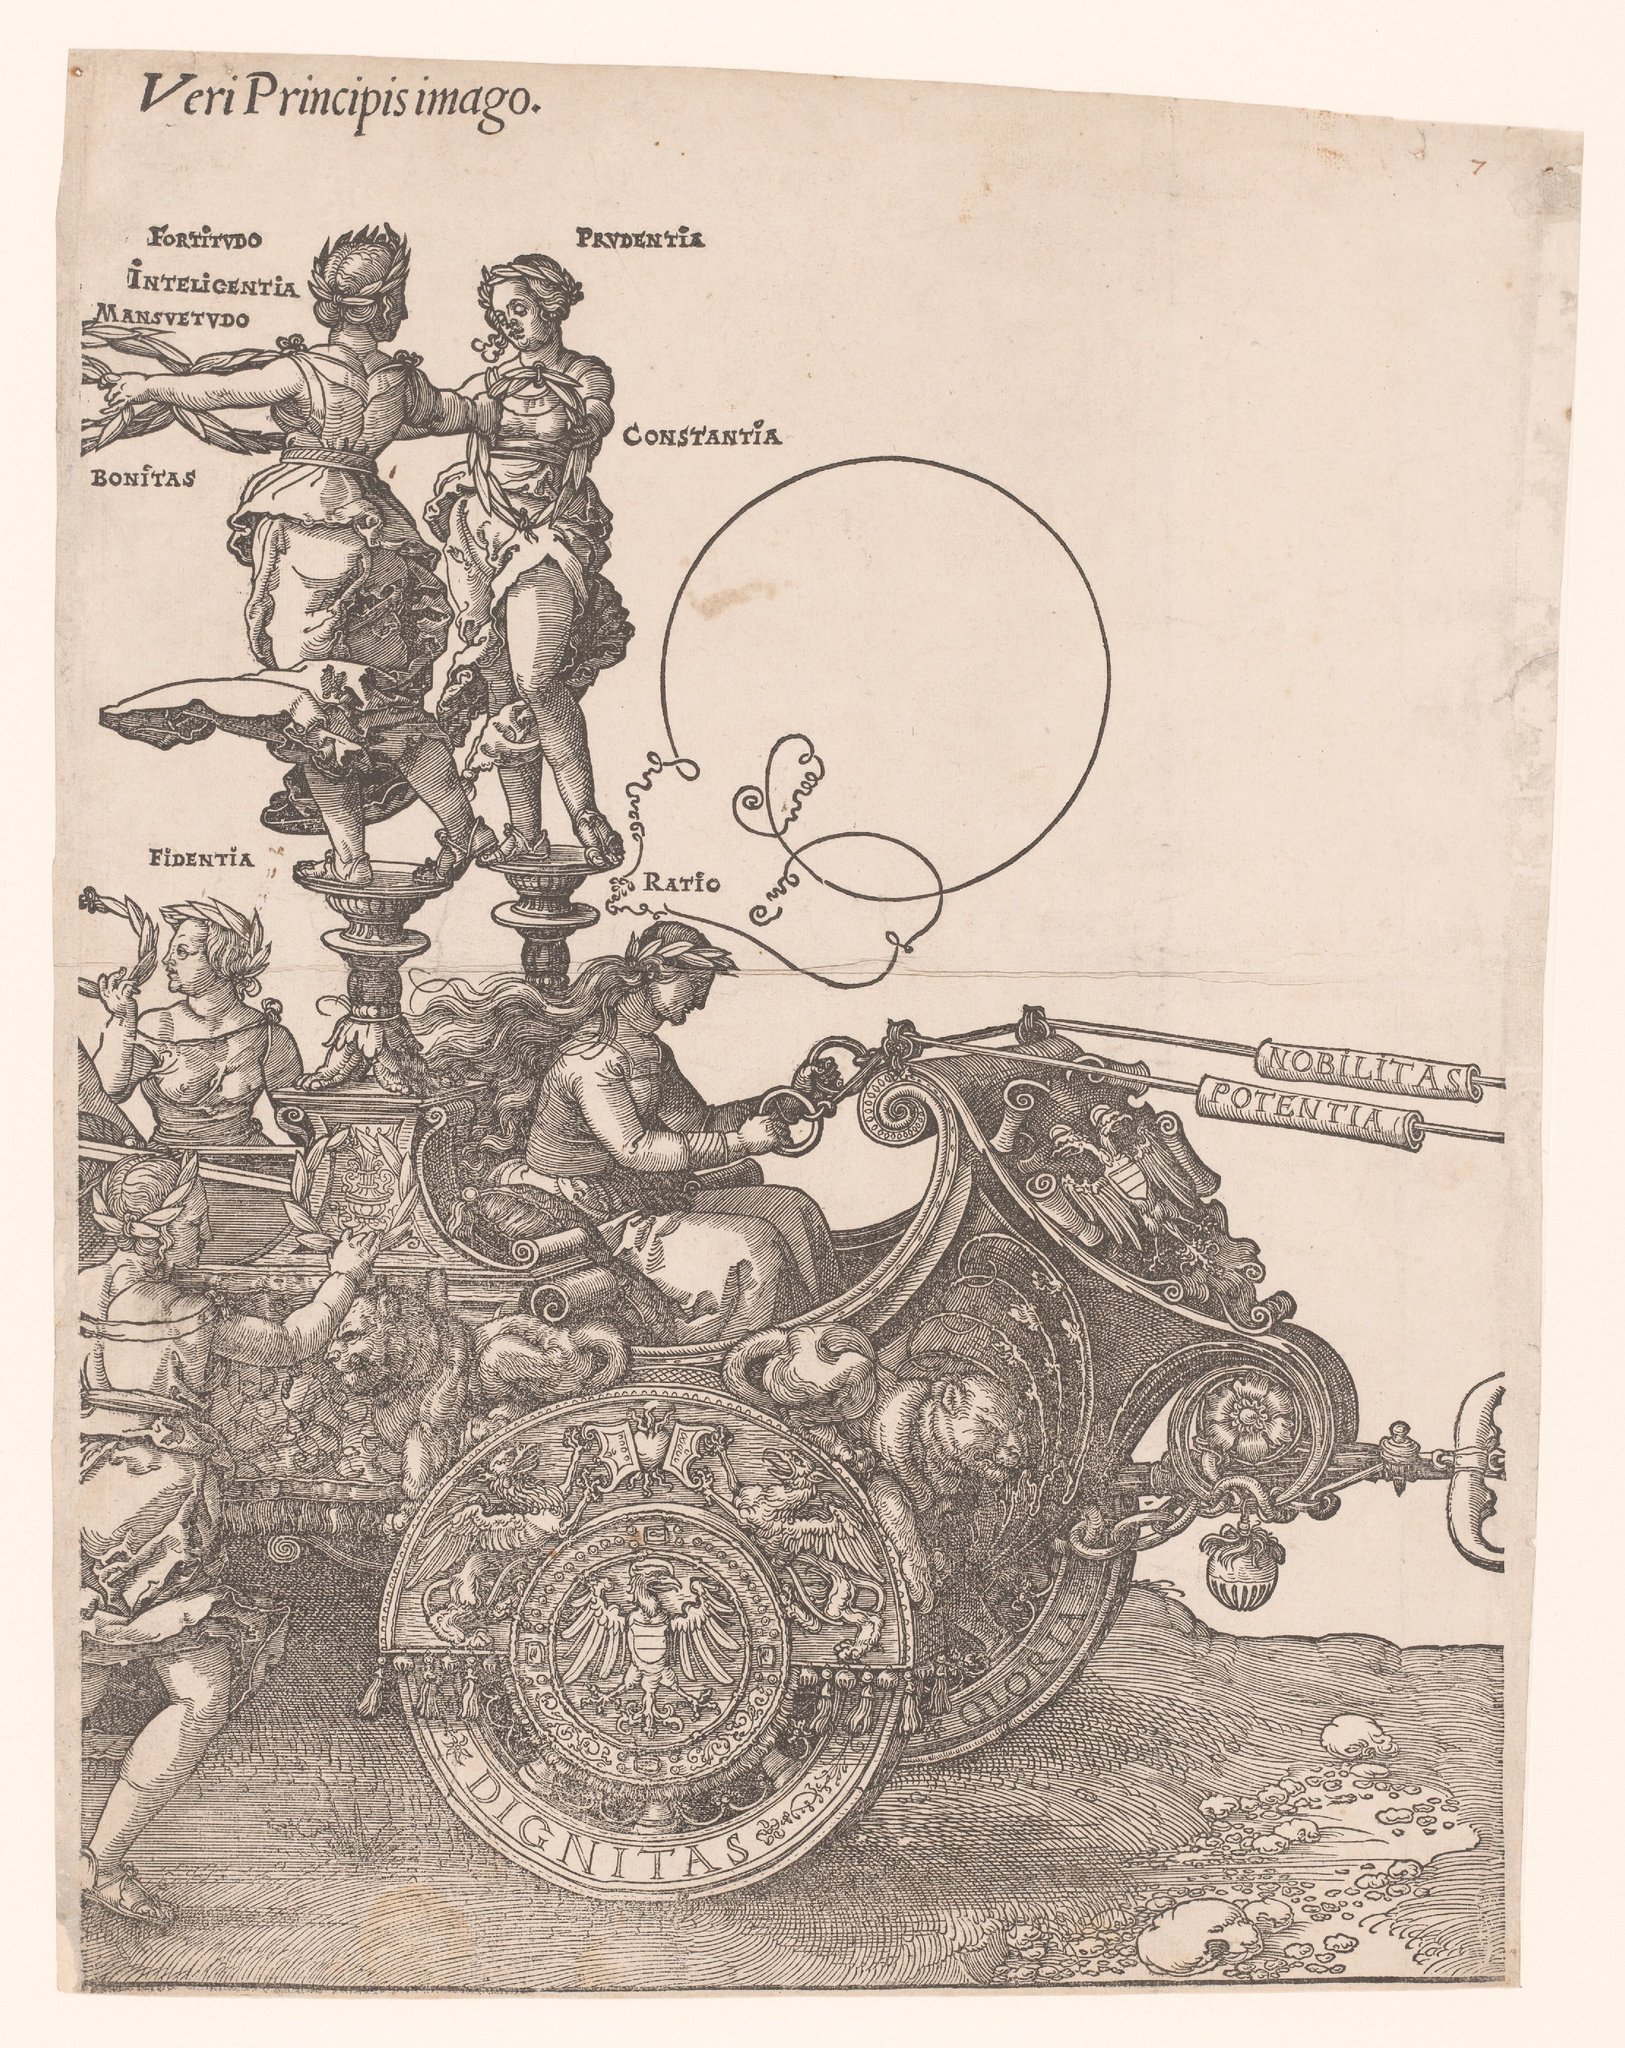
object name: print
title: Triumphalis his currus ad honorem Invictiss. ac Gloriosiss. Principis D. Maximiliani Caesaris semper Augusti (...) per Albertum Durer delineatus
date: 1527-1529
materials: paper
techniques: woodcut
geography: antwerp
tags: maximilian i (holy roman emperor), chariot, triumphal car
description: De grote triomfwagen ter ere van keizer Maximiliaan I bij zijn overlijden op 12 januari 1519. Tweede blad met het rechterdeel van de triomfwagen met de deugden Ratio en Fidentia.